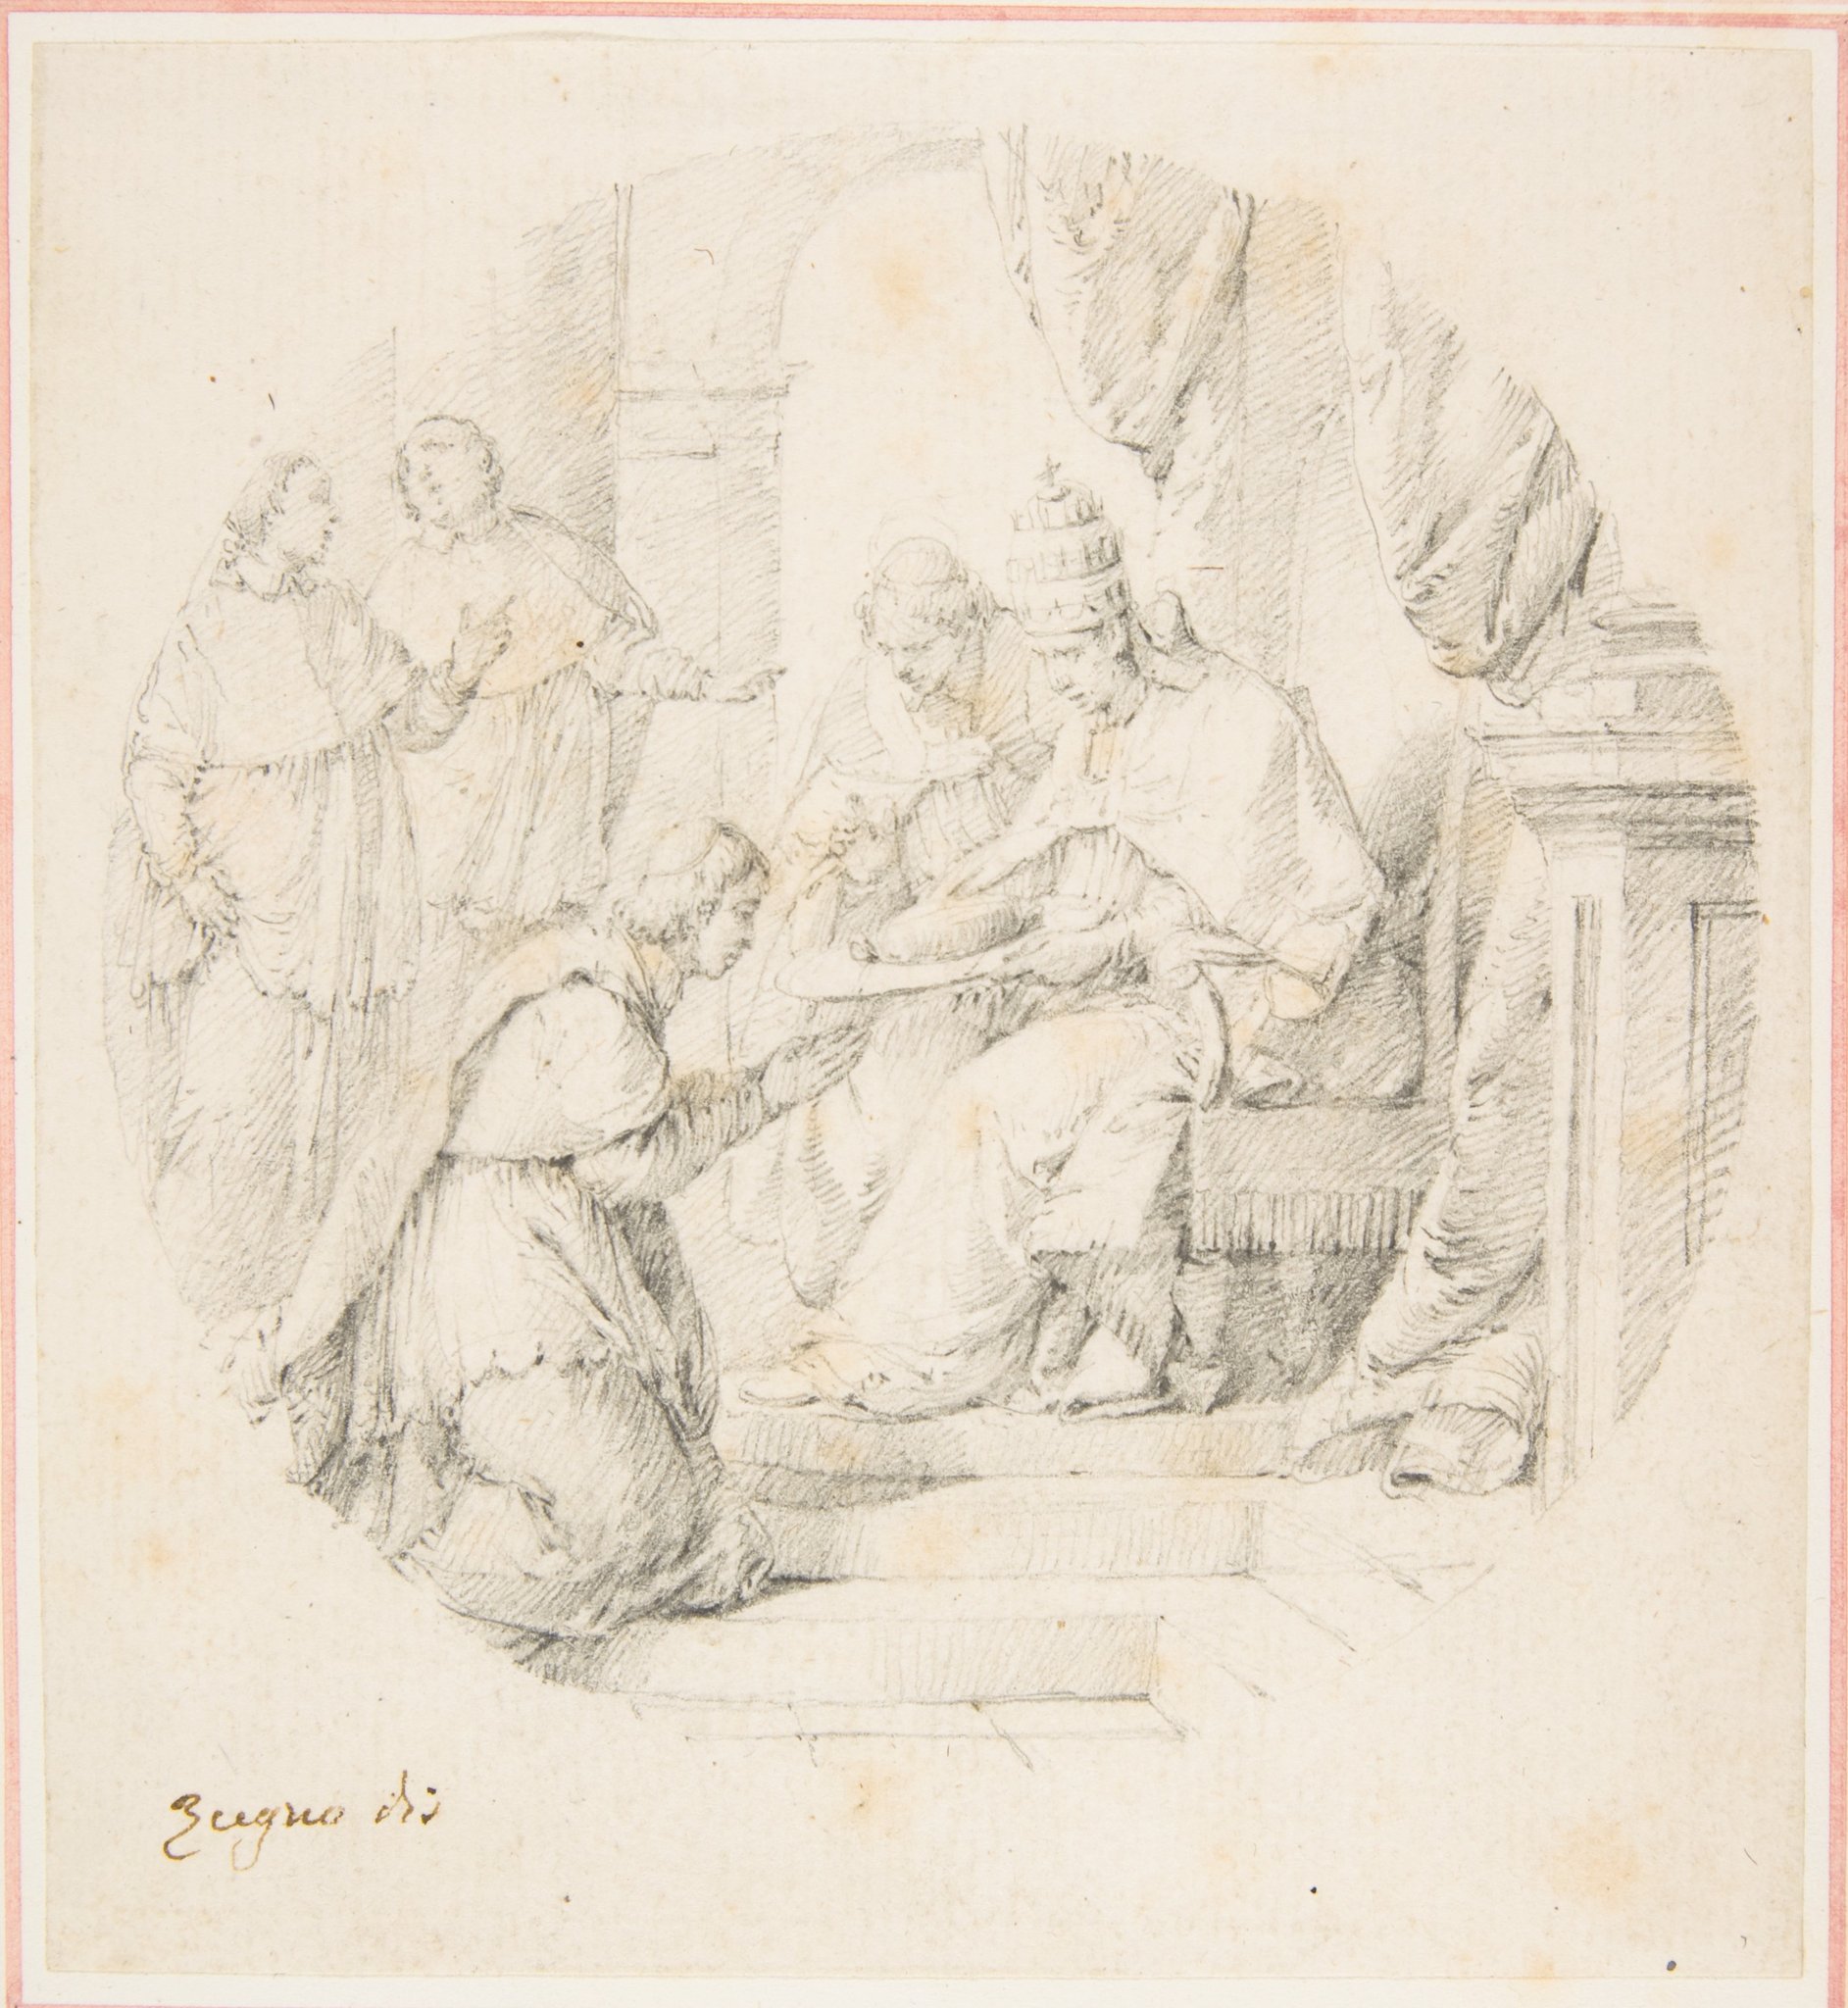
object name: drawing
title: Angelo Maria Querini Created Cardinal by Benedict XIII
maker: francesco zugno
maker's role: artist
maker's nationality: italian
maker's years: 1709-1787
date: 1709-1787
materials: graphite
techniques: drawing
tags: men,popes